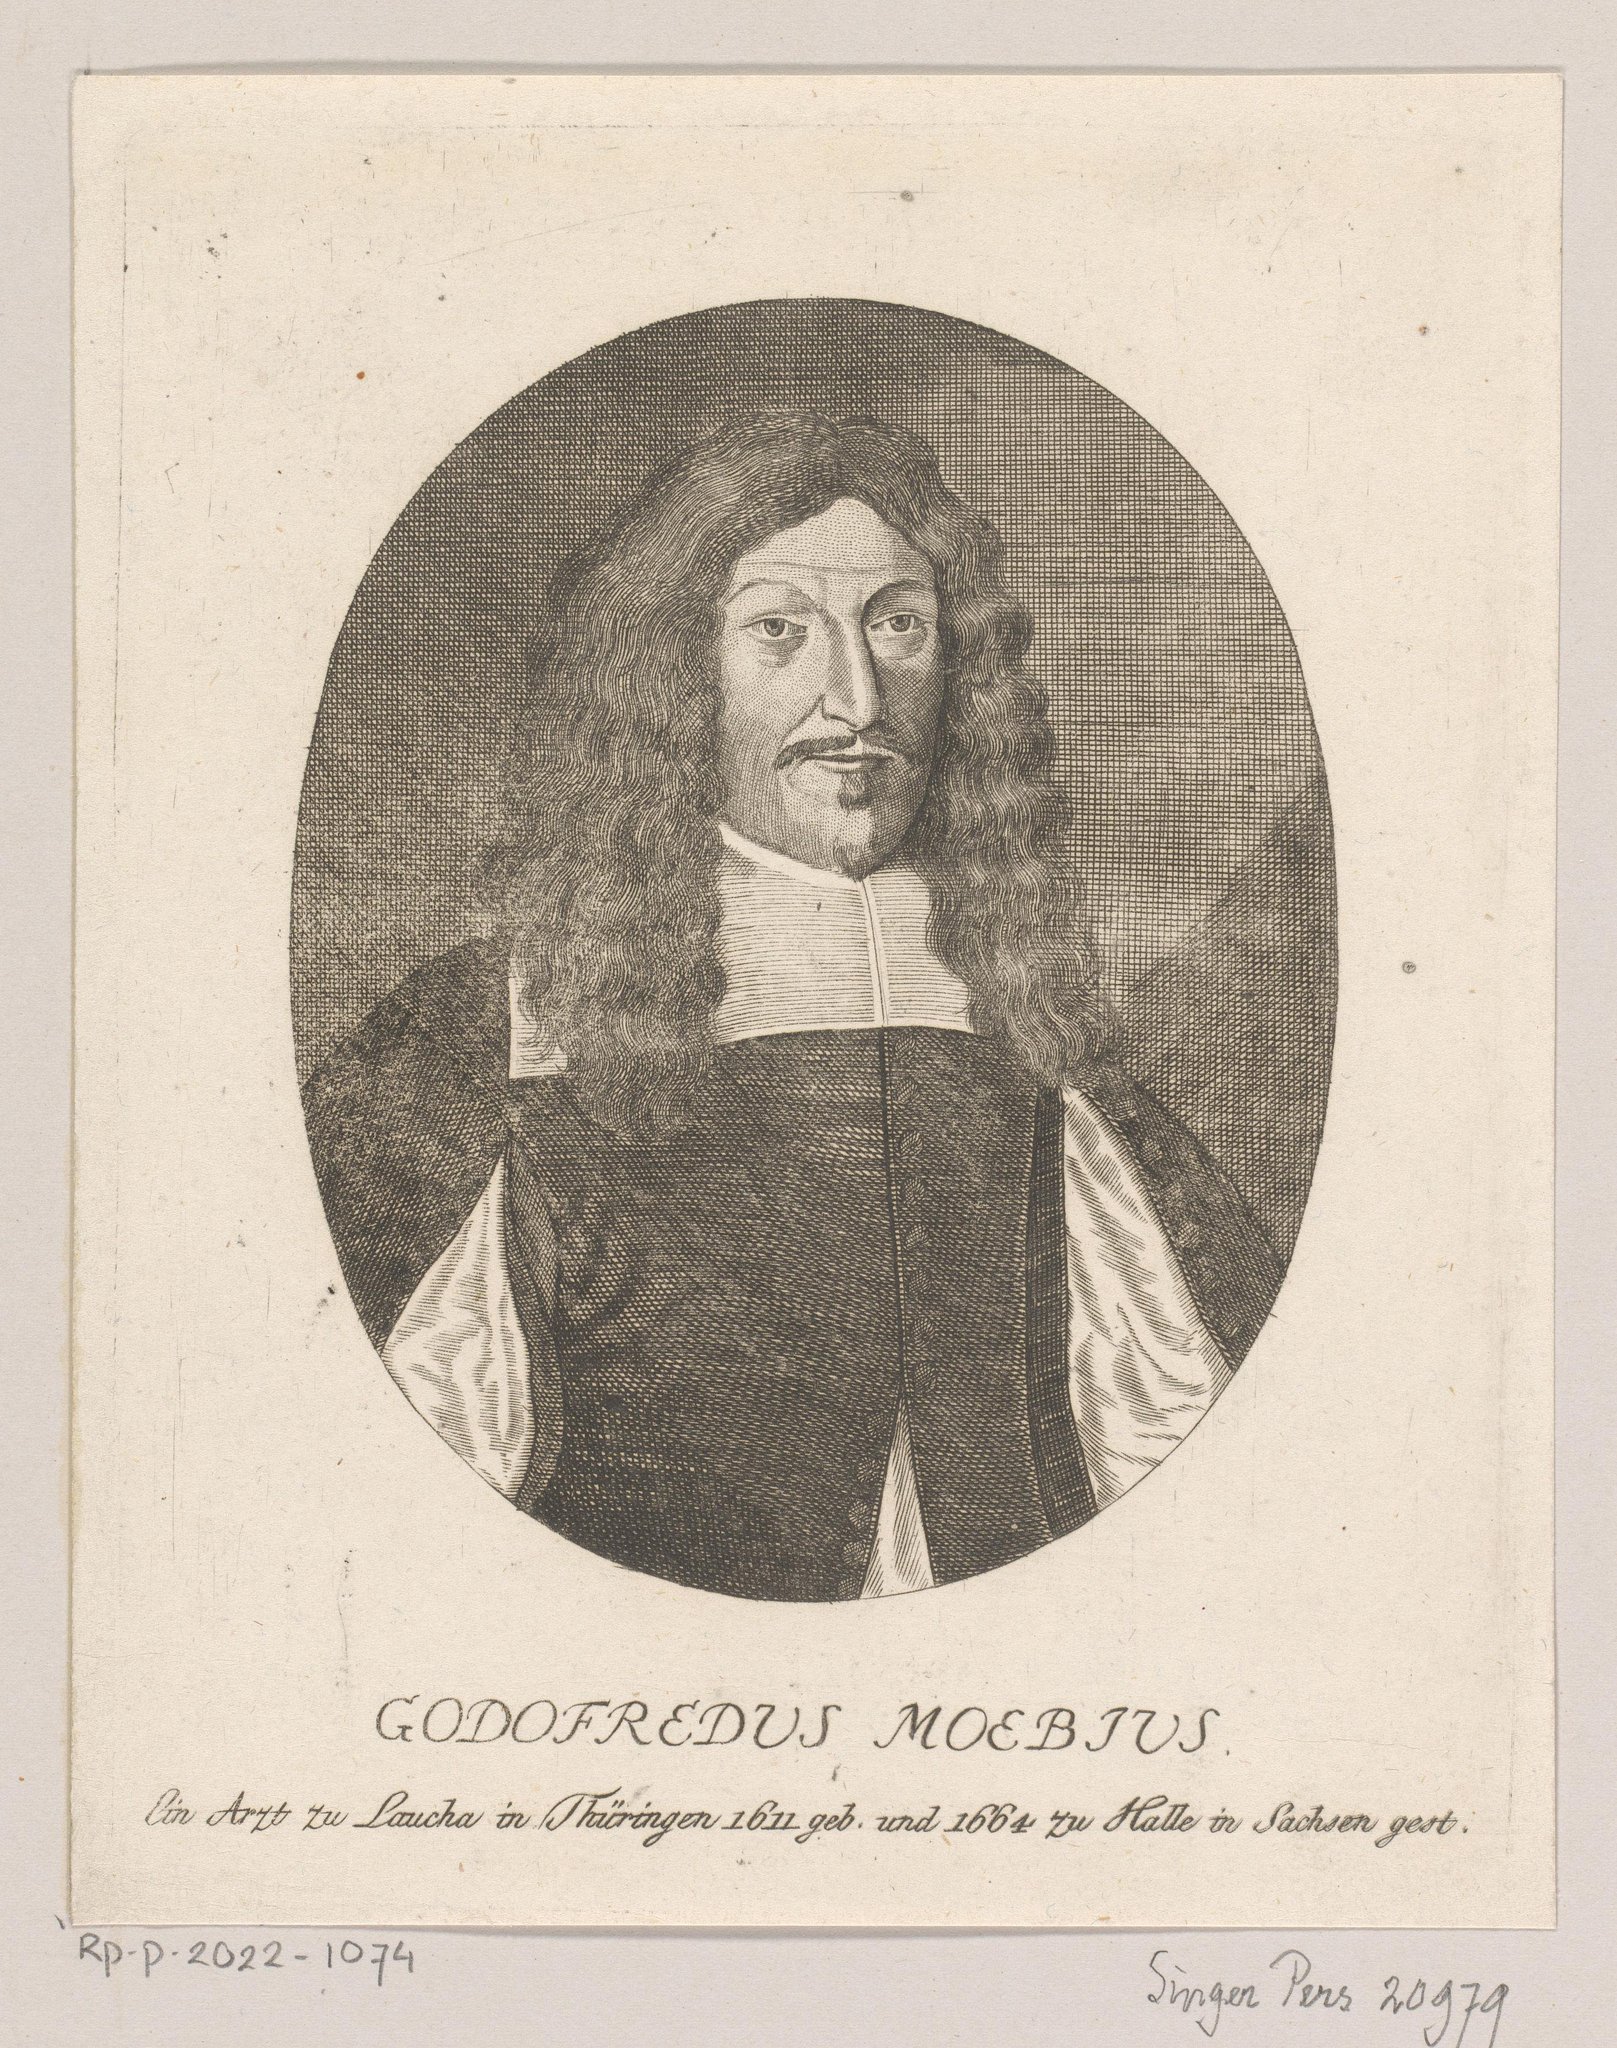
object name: print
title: Portret van Gottfried Moebius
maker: Anonymous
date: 1664-1699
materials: paper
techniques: engraving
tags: historical persons, physician, doctor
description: Met eenregelig onderschrift in het Duits.